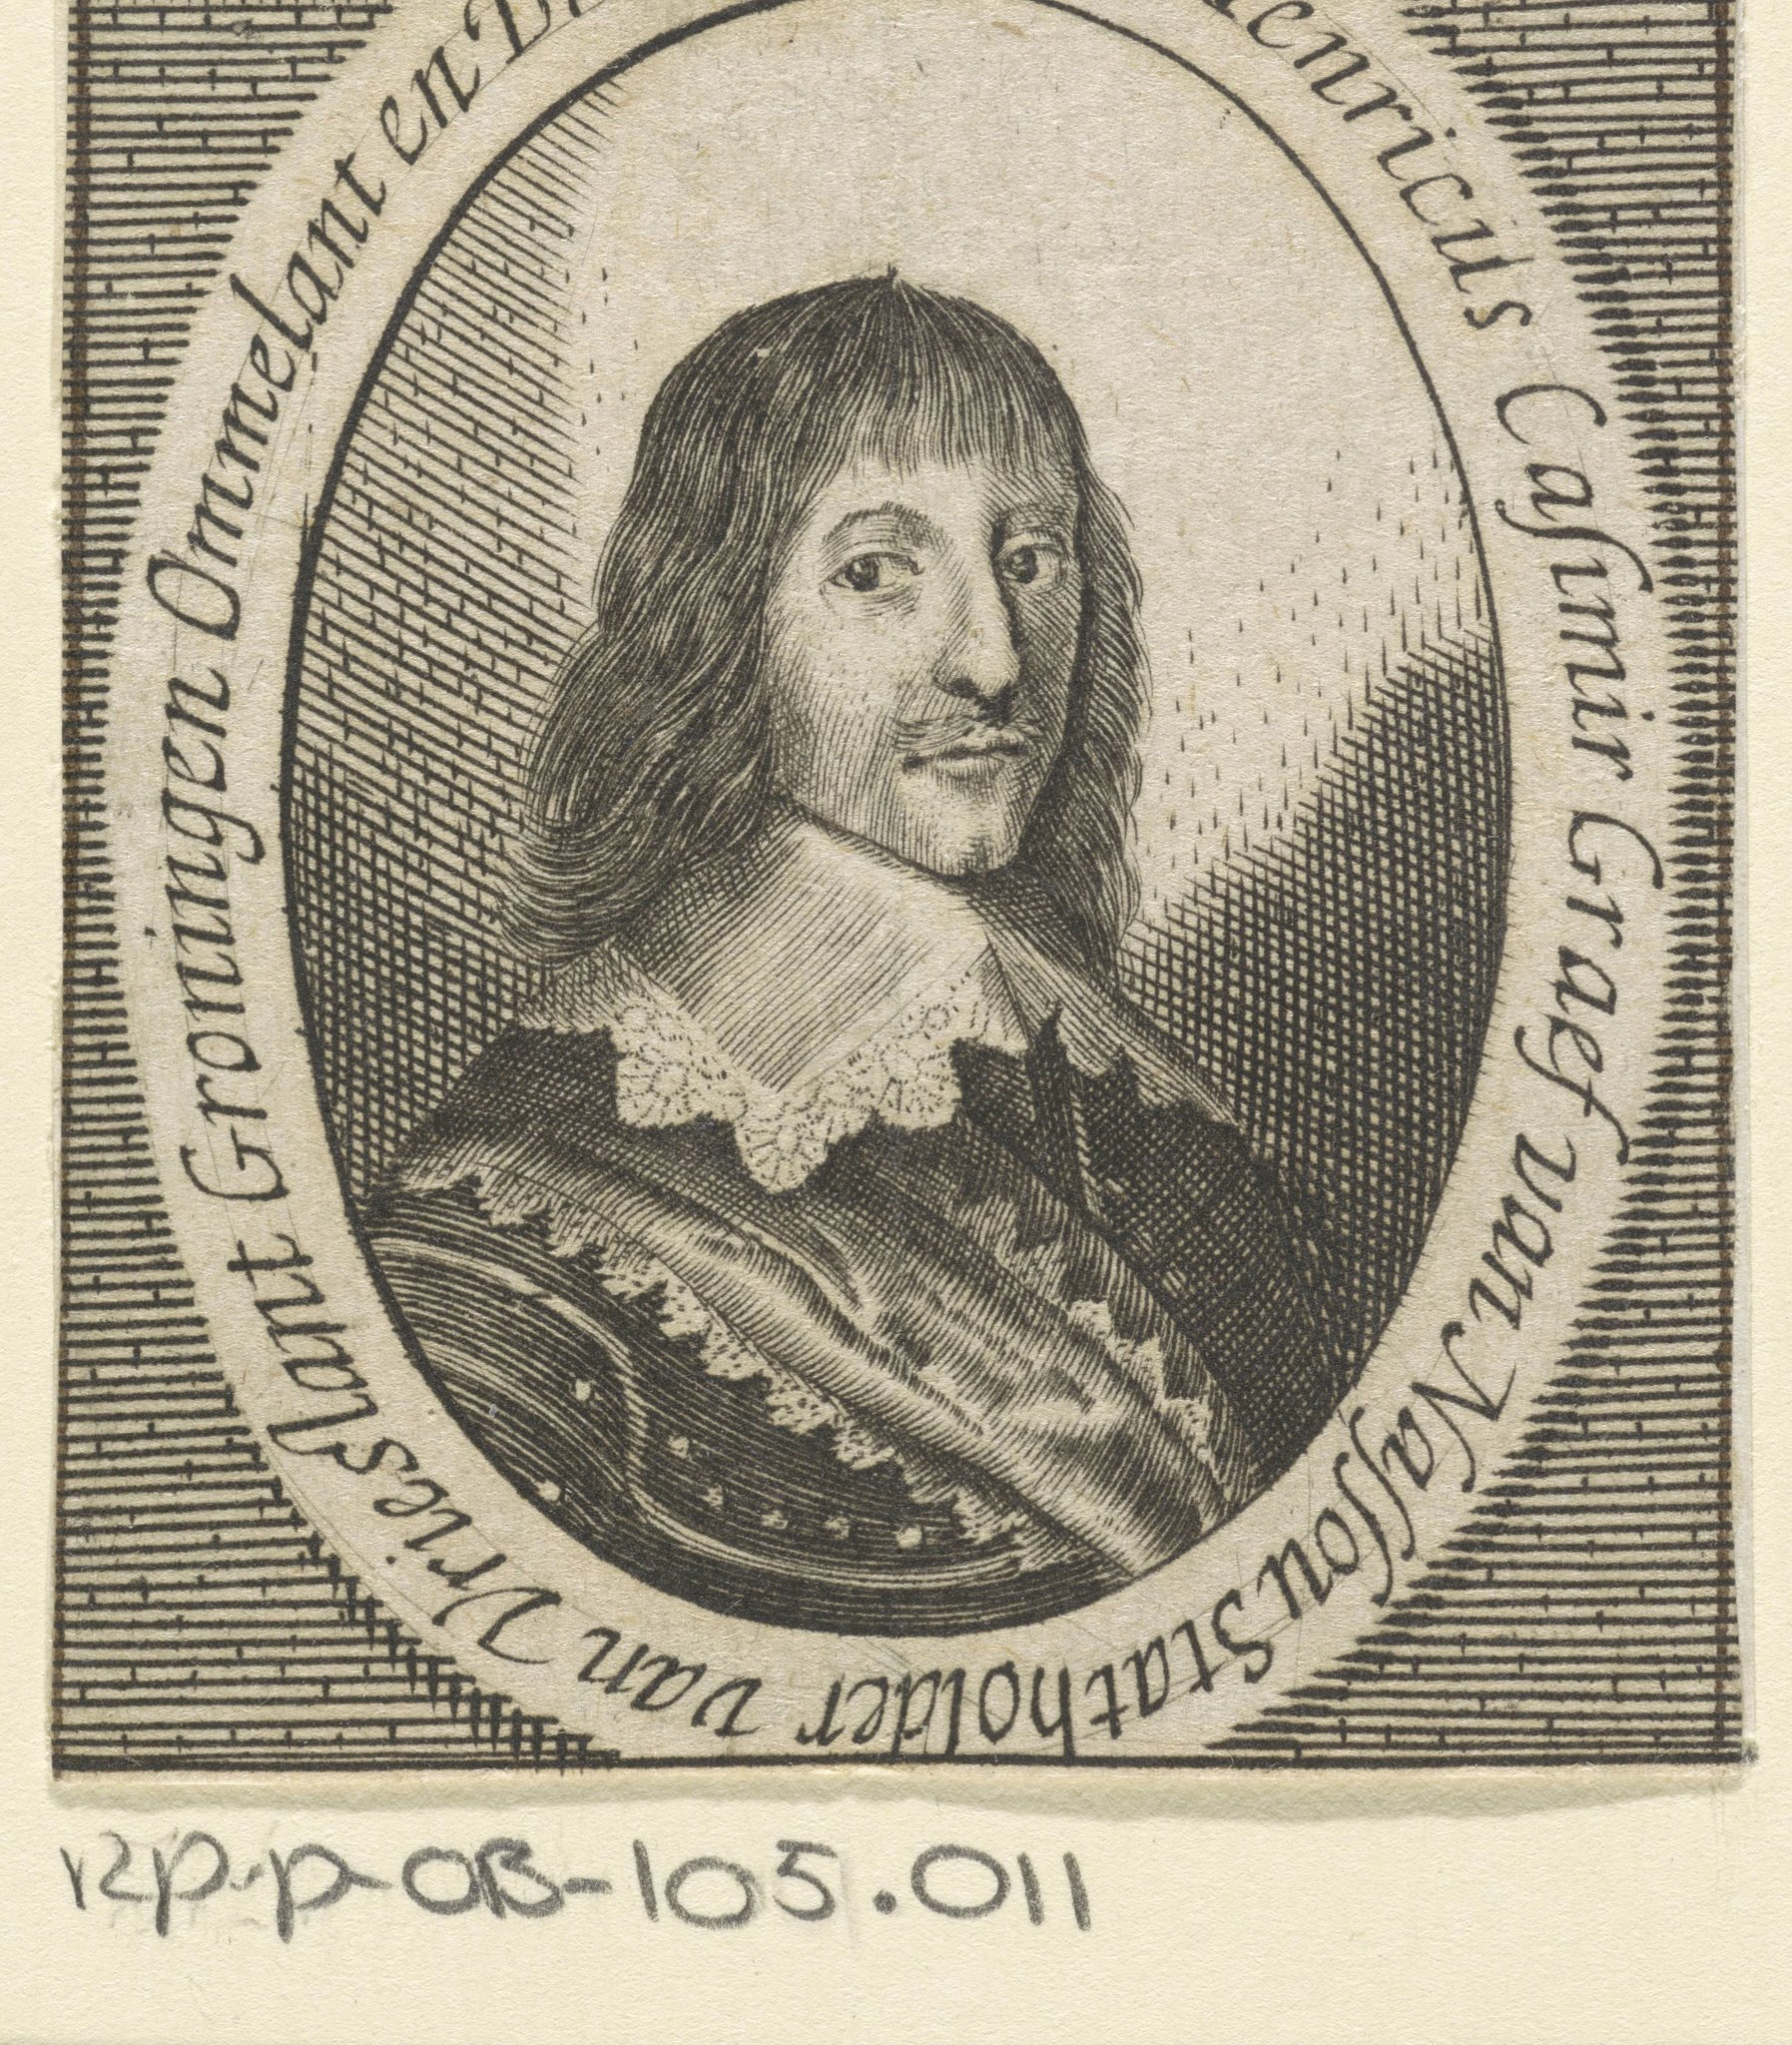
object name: print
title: Portret van Hendrik Casimir I, graaf van Nassau-Dietz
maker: Anonymous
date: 1630-1699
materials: paper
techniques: engraving, etching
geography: low countries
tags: arnhem, hendrik casimir i graaf van nassau-dietz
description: De hier vermelde titel verwijst naar de hoogst verkregen titel van de geportretteerde, niet per se naar de titel die de geportretteerde op deze voorstelling draagt.